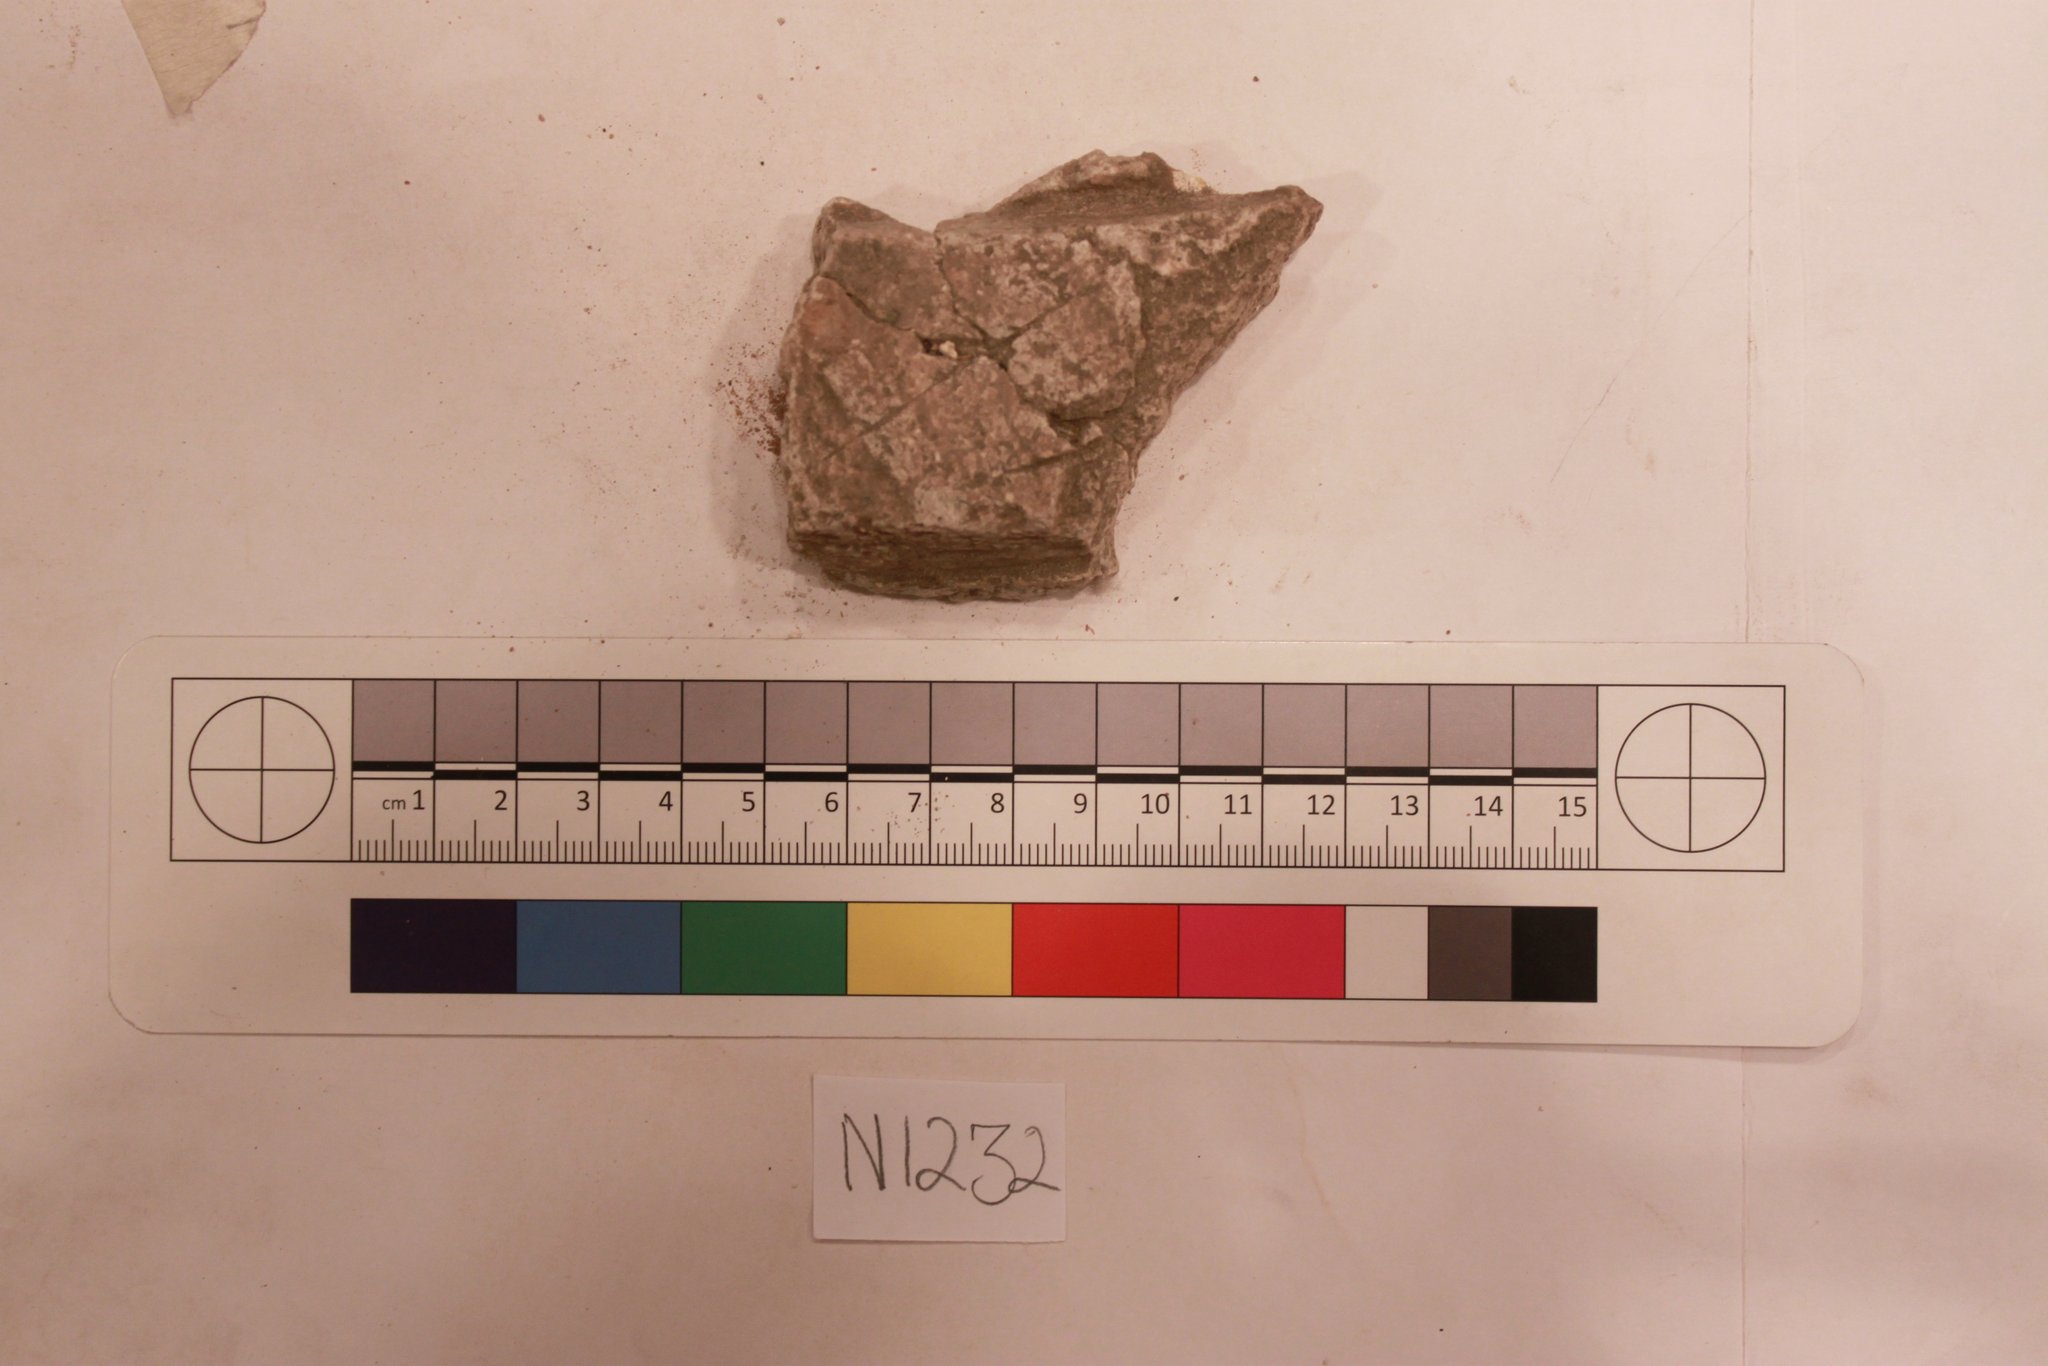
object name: fragment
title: Stucco Fragment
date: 701-1200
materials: plaster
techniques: carving, painting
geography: iran